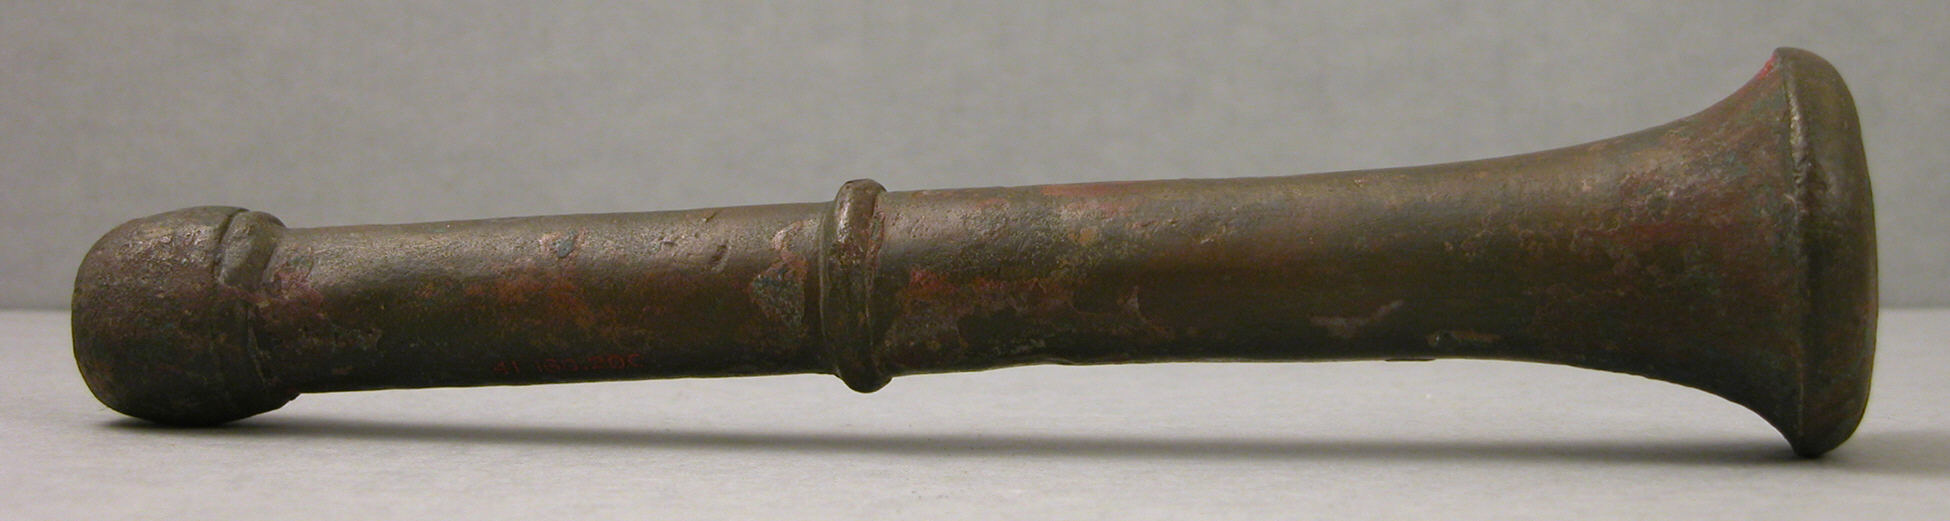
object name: pestle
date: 1301-1400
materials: bronze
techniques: gilding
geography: iran